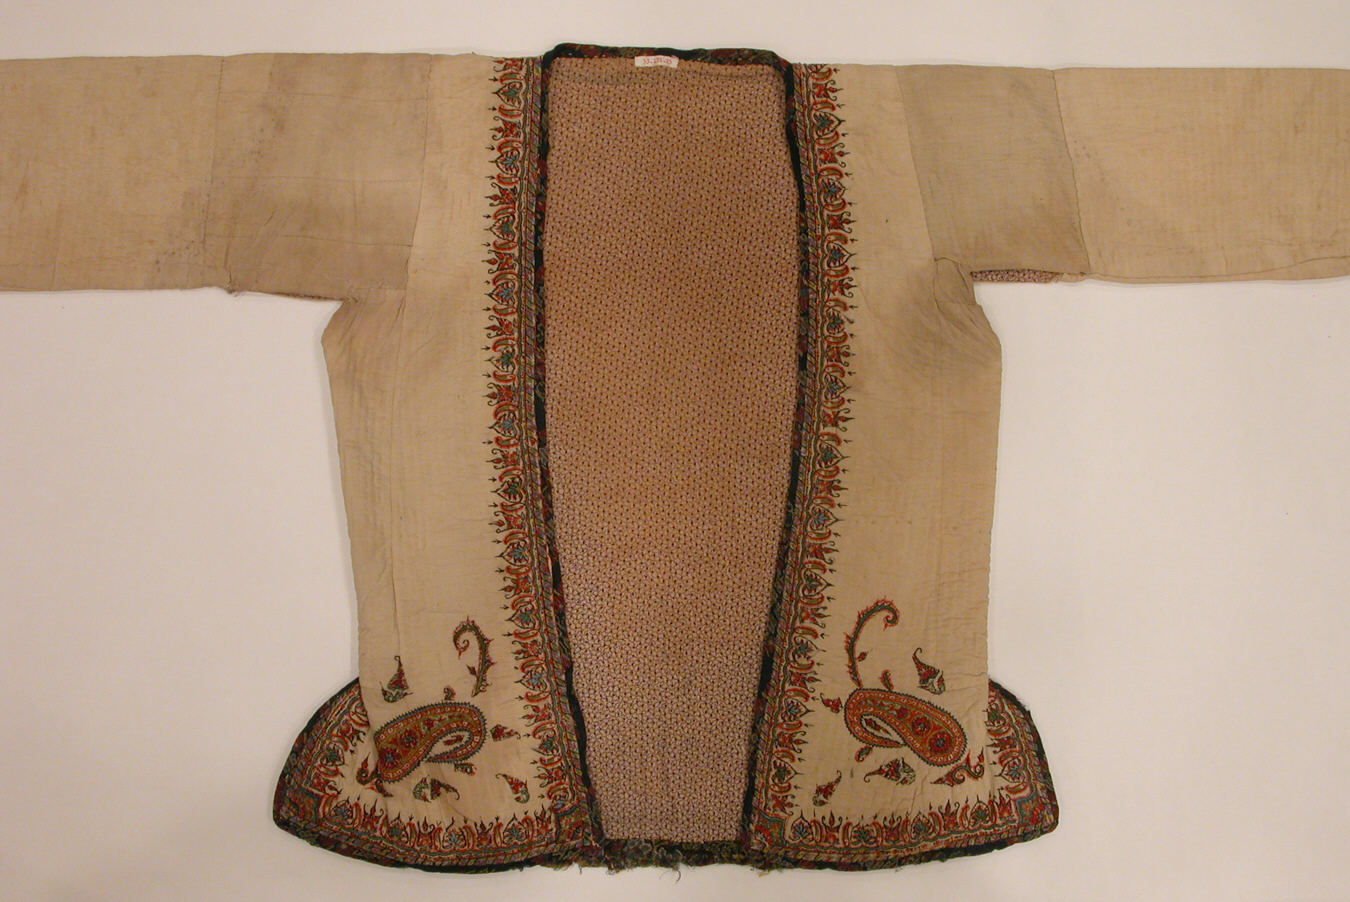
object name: jacket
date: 1801-1833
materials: wool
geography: iran